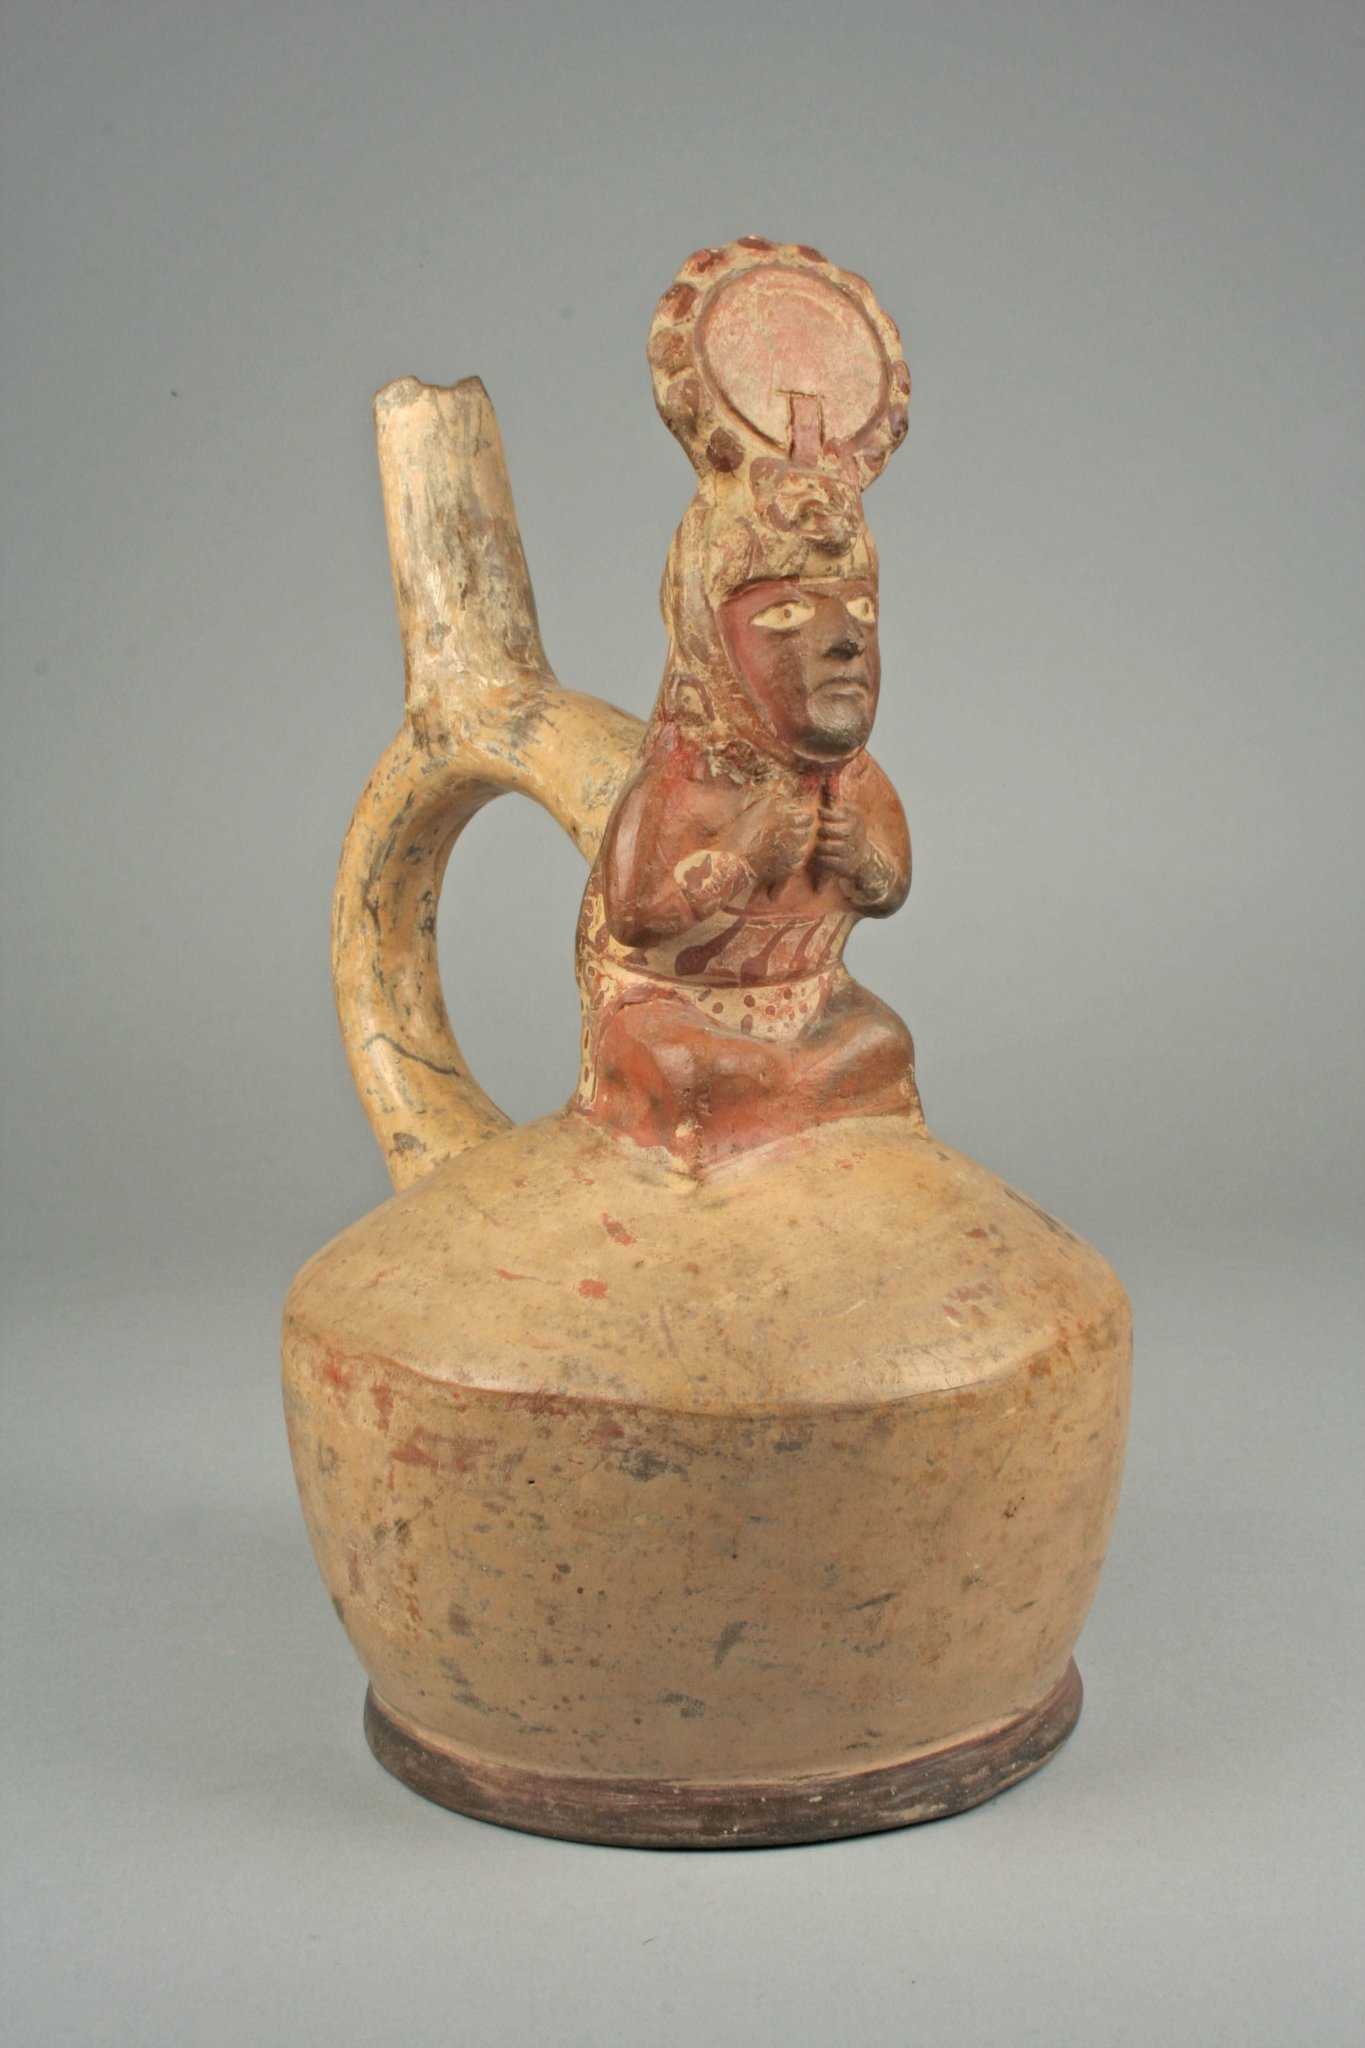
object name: bottle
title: Stirrup spout bottle with figure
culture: moche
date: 501-700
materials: ceramic, pigment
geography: peru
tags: human figures